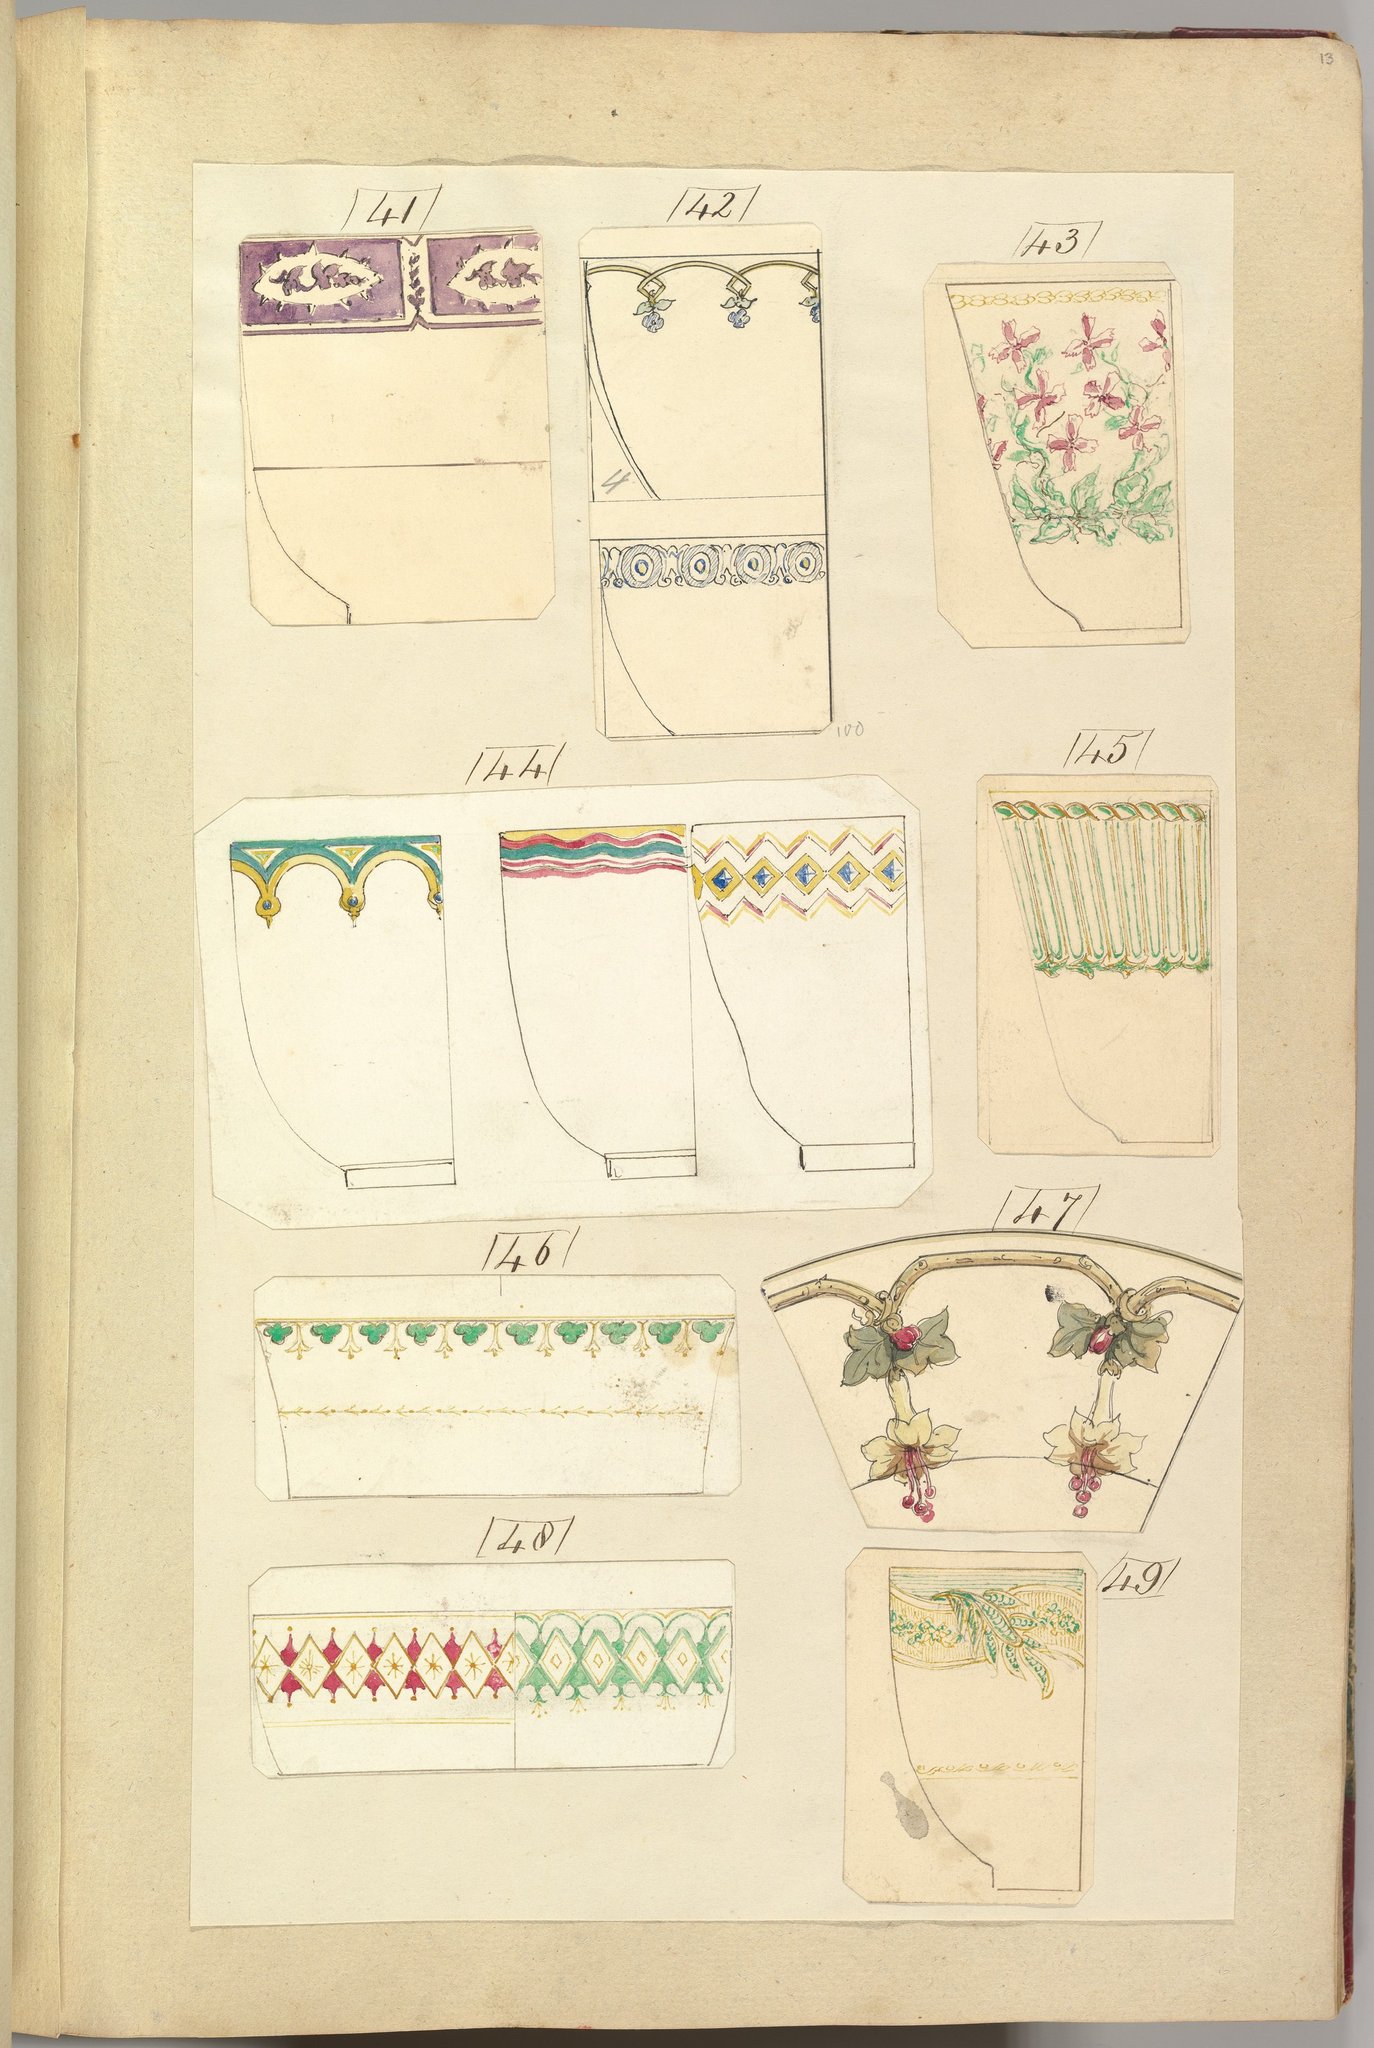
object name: drawing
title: Thirteen Designs for Decorated Cups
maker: alfred henry forrester [alfred crowquill]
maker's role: artist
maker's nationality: british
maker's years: 1804-1872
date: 1845-1855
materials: ink, watercolor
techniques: pen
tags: flowers